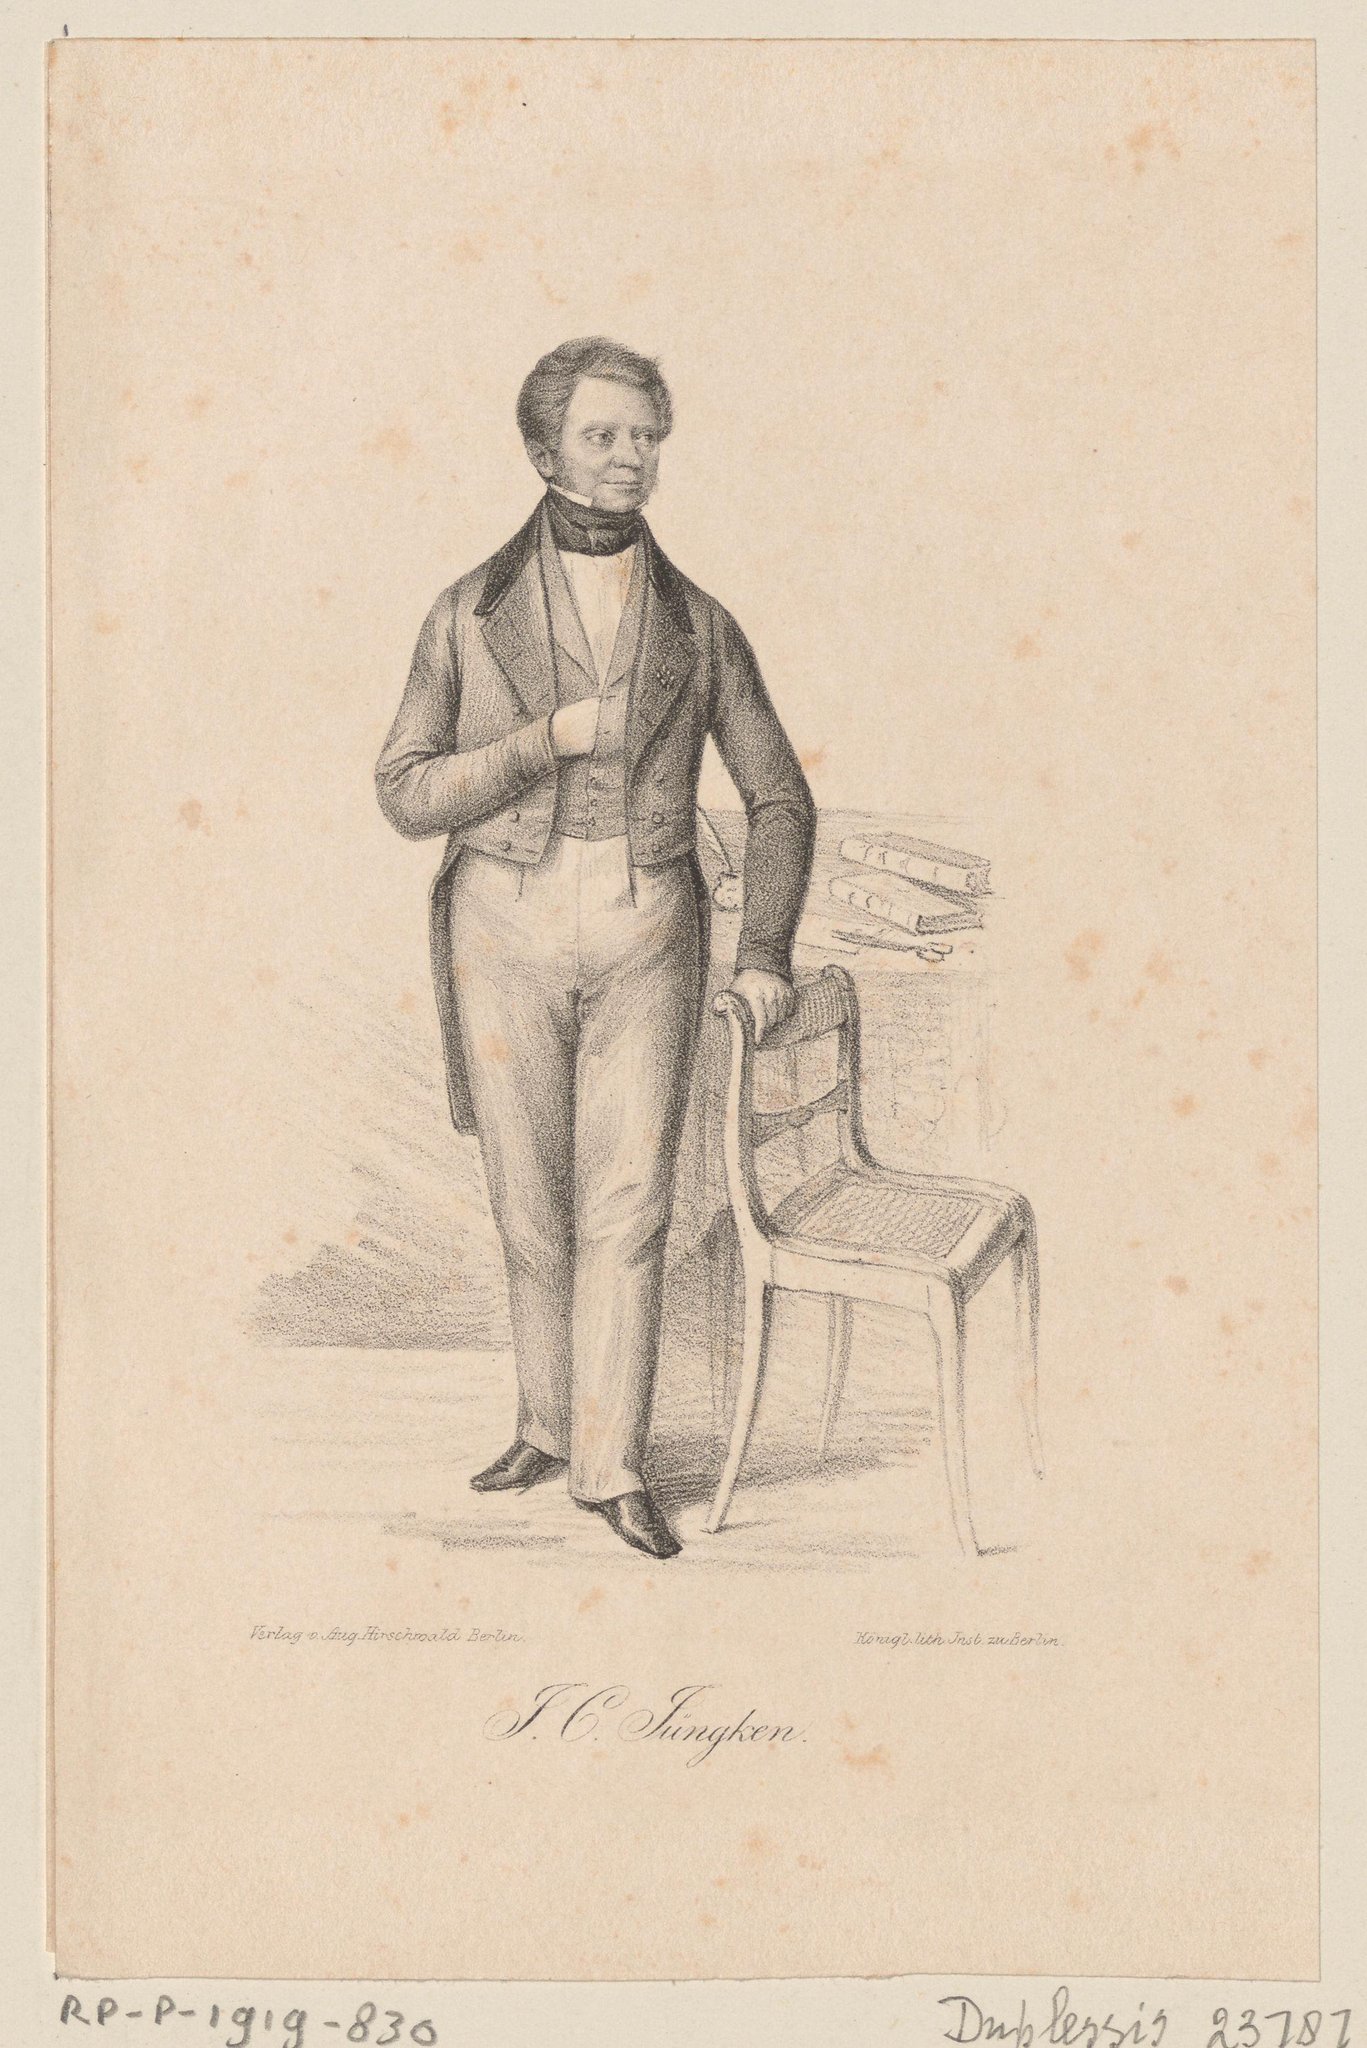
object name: print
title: Portret van Johann Christian Jüngken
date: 1818-1840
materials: paper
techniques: lithograph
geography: berlin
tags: standing figure, historical persons, barber; surgeon, chair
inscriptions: collector's mark: Lugt 2228